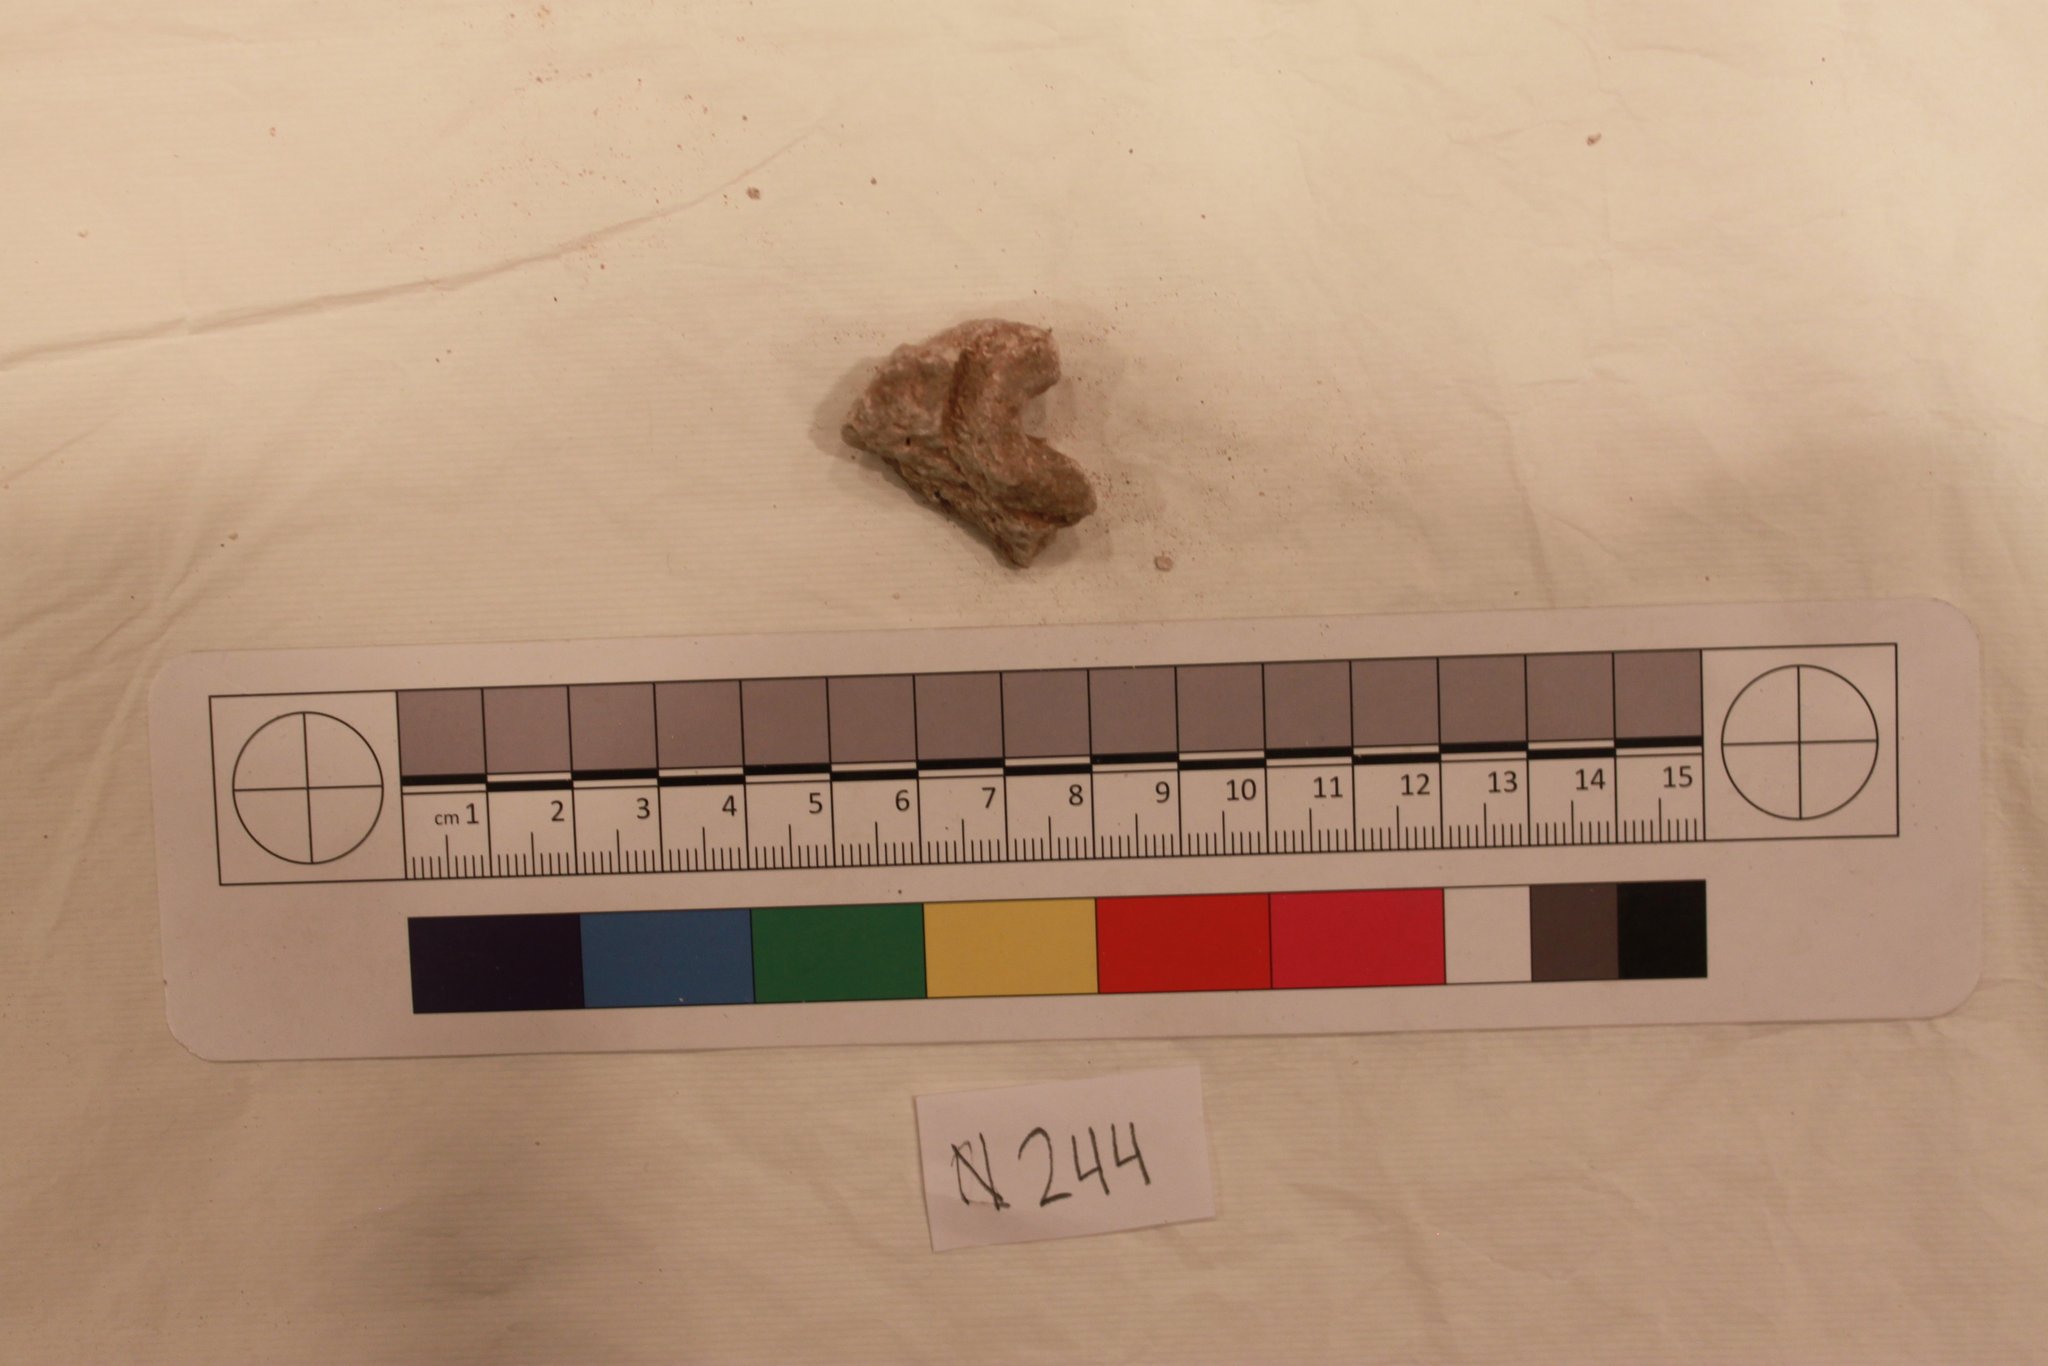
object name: fragment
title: Stucco Fragment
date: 701-1200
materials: plaster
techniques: carving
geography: iran